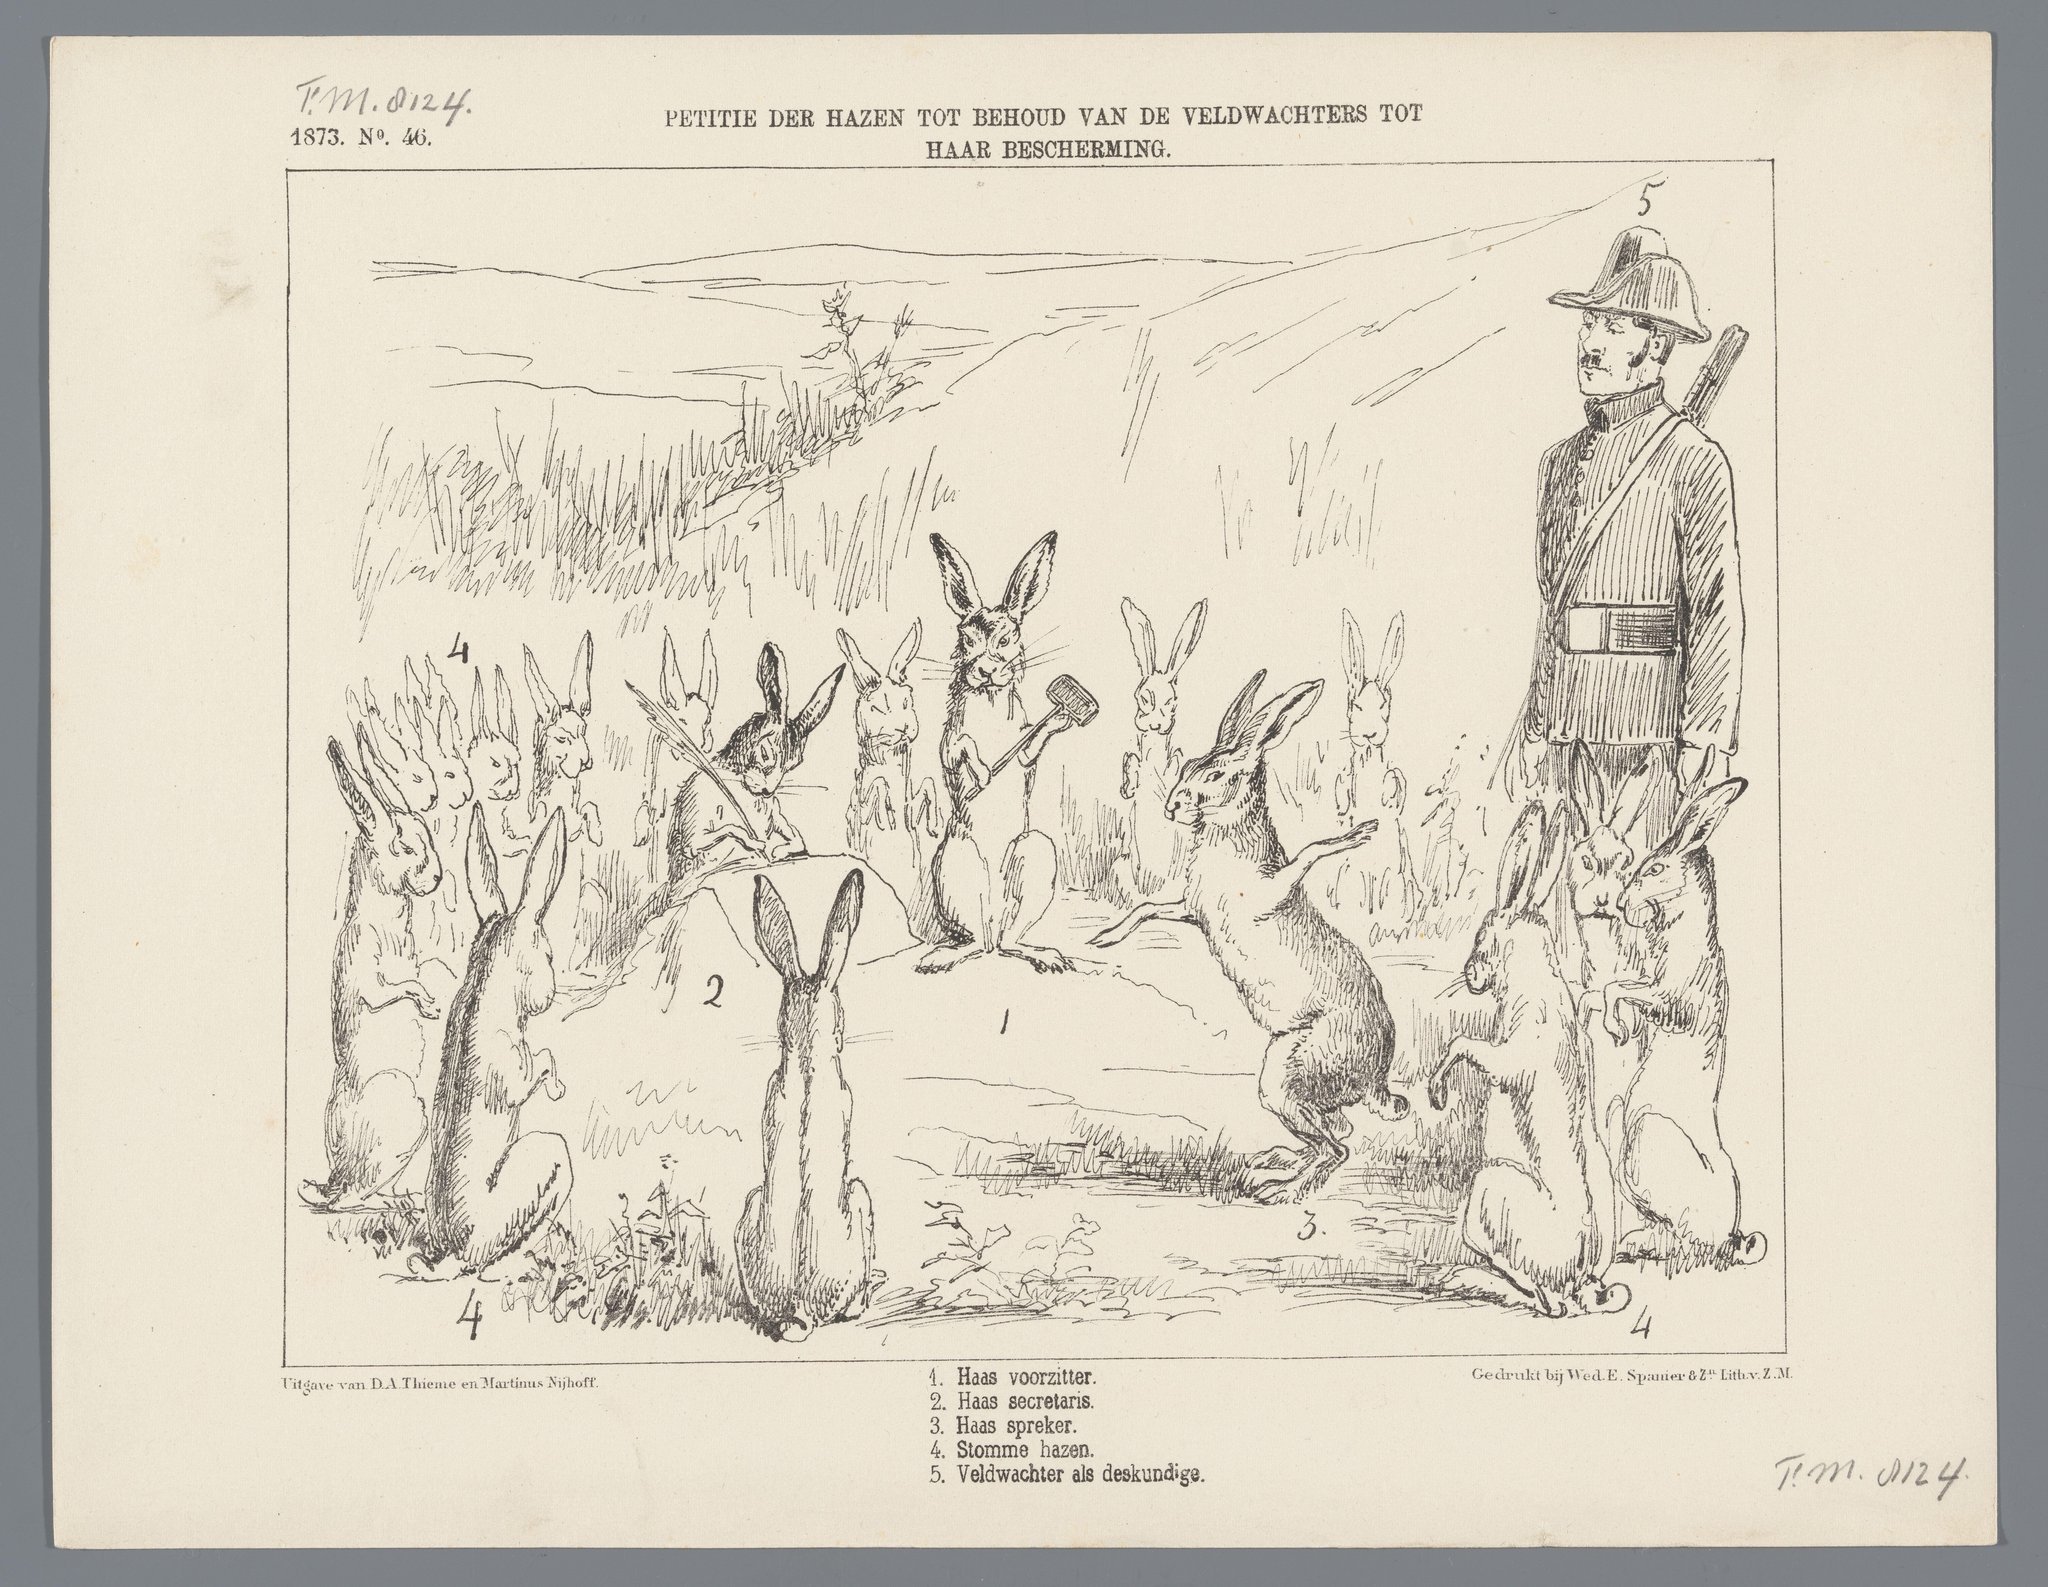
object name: print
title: Spotprent op het voorstel ter verandering van de jachtwet, 1873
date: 1873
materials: paper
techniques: lithograph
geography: arnhem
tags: game, hunted animals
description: Spotprent op het voorstel van Mr. Gratema ter verandering van de jachtwet. Plaat verschenen bij het weekblad De Nederlandsche Spectator, nr. 46, 1873.